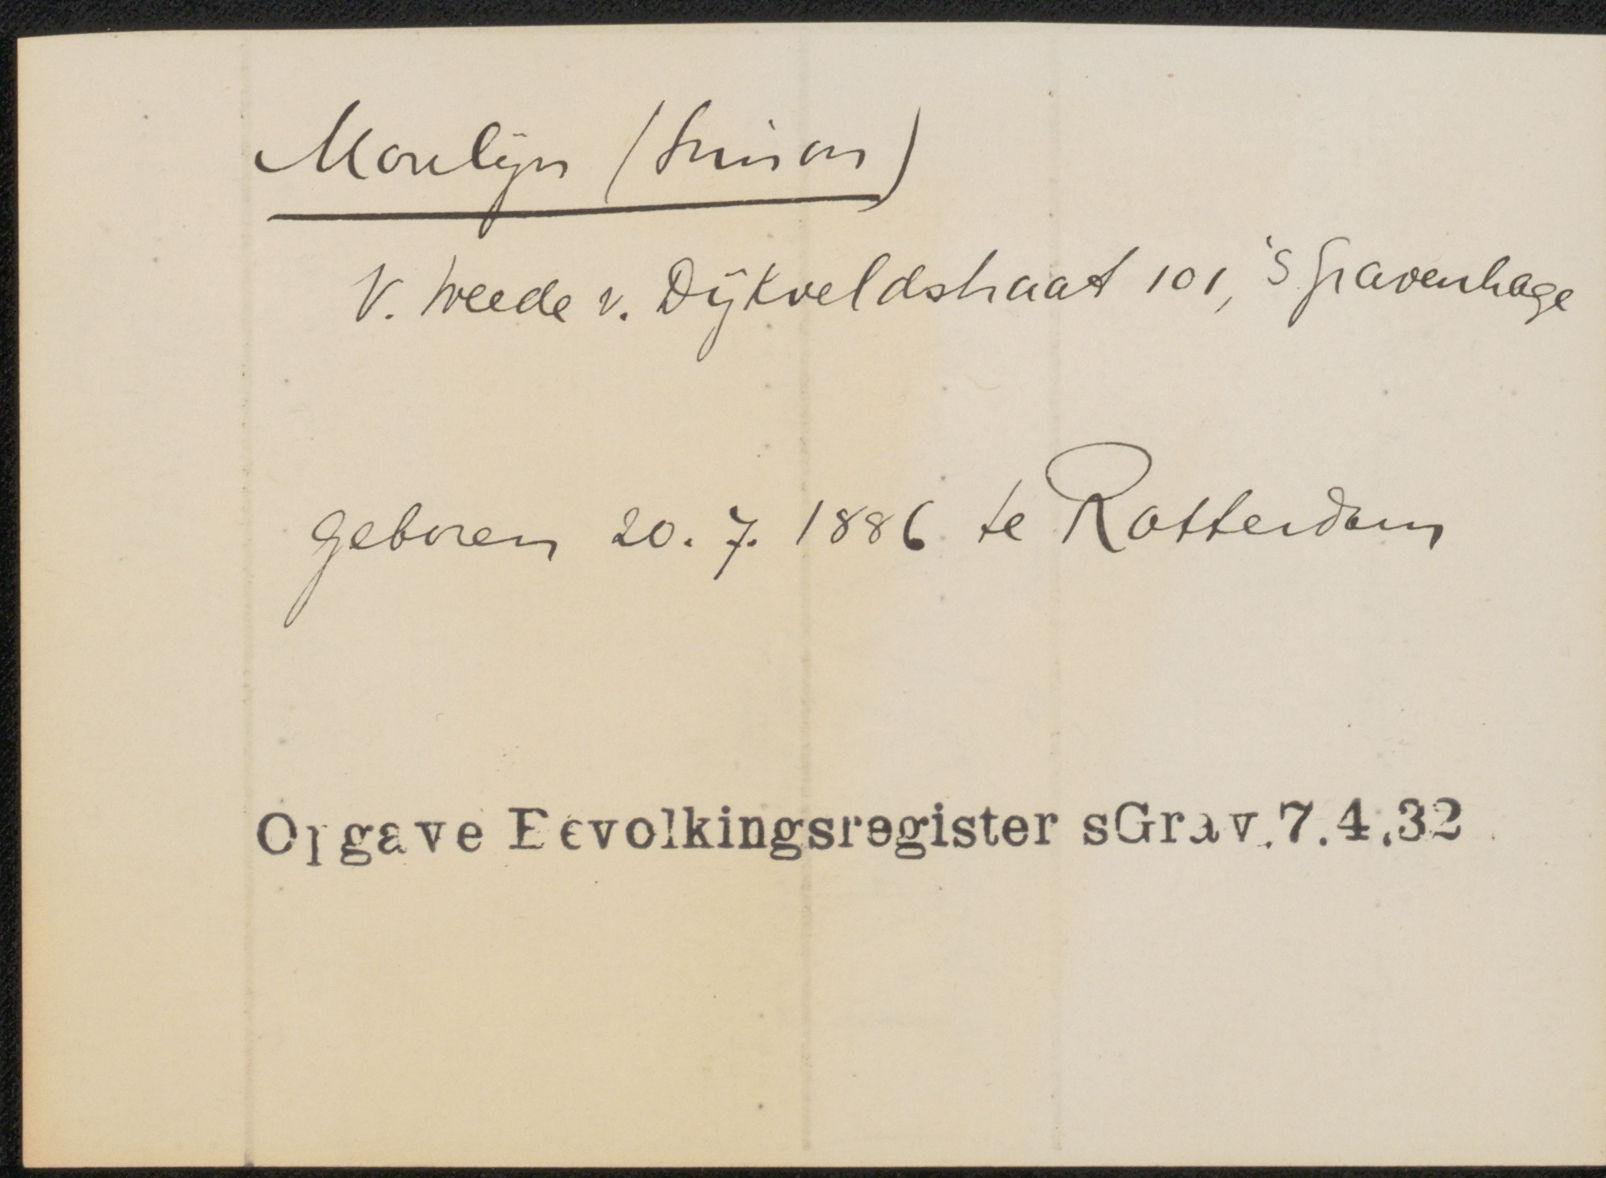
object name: aantekening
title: Aantekening betreffende Simon Moulijn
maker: Anonymous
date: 1932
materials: ink, paper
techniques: pen, writing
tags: rotterdam, draughtsman, simon moulijn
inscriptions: stamp: ‘Opgave Bevolkingsregister sGrav.7.4.32’